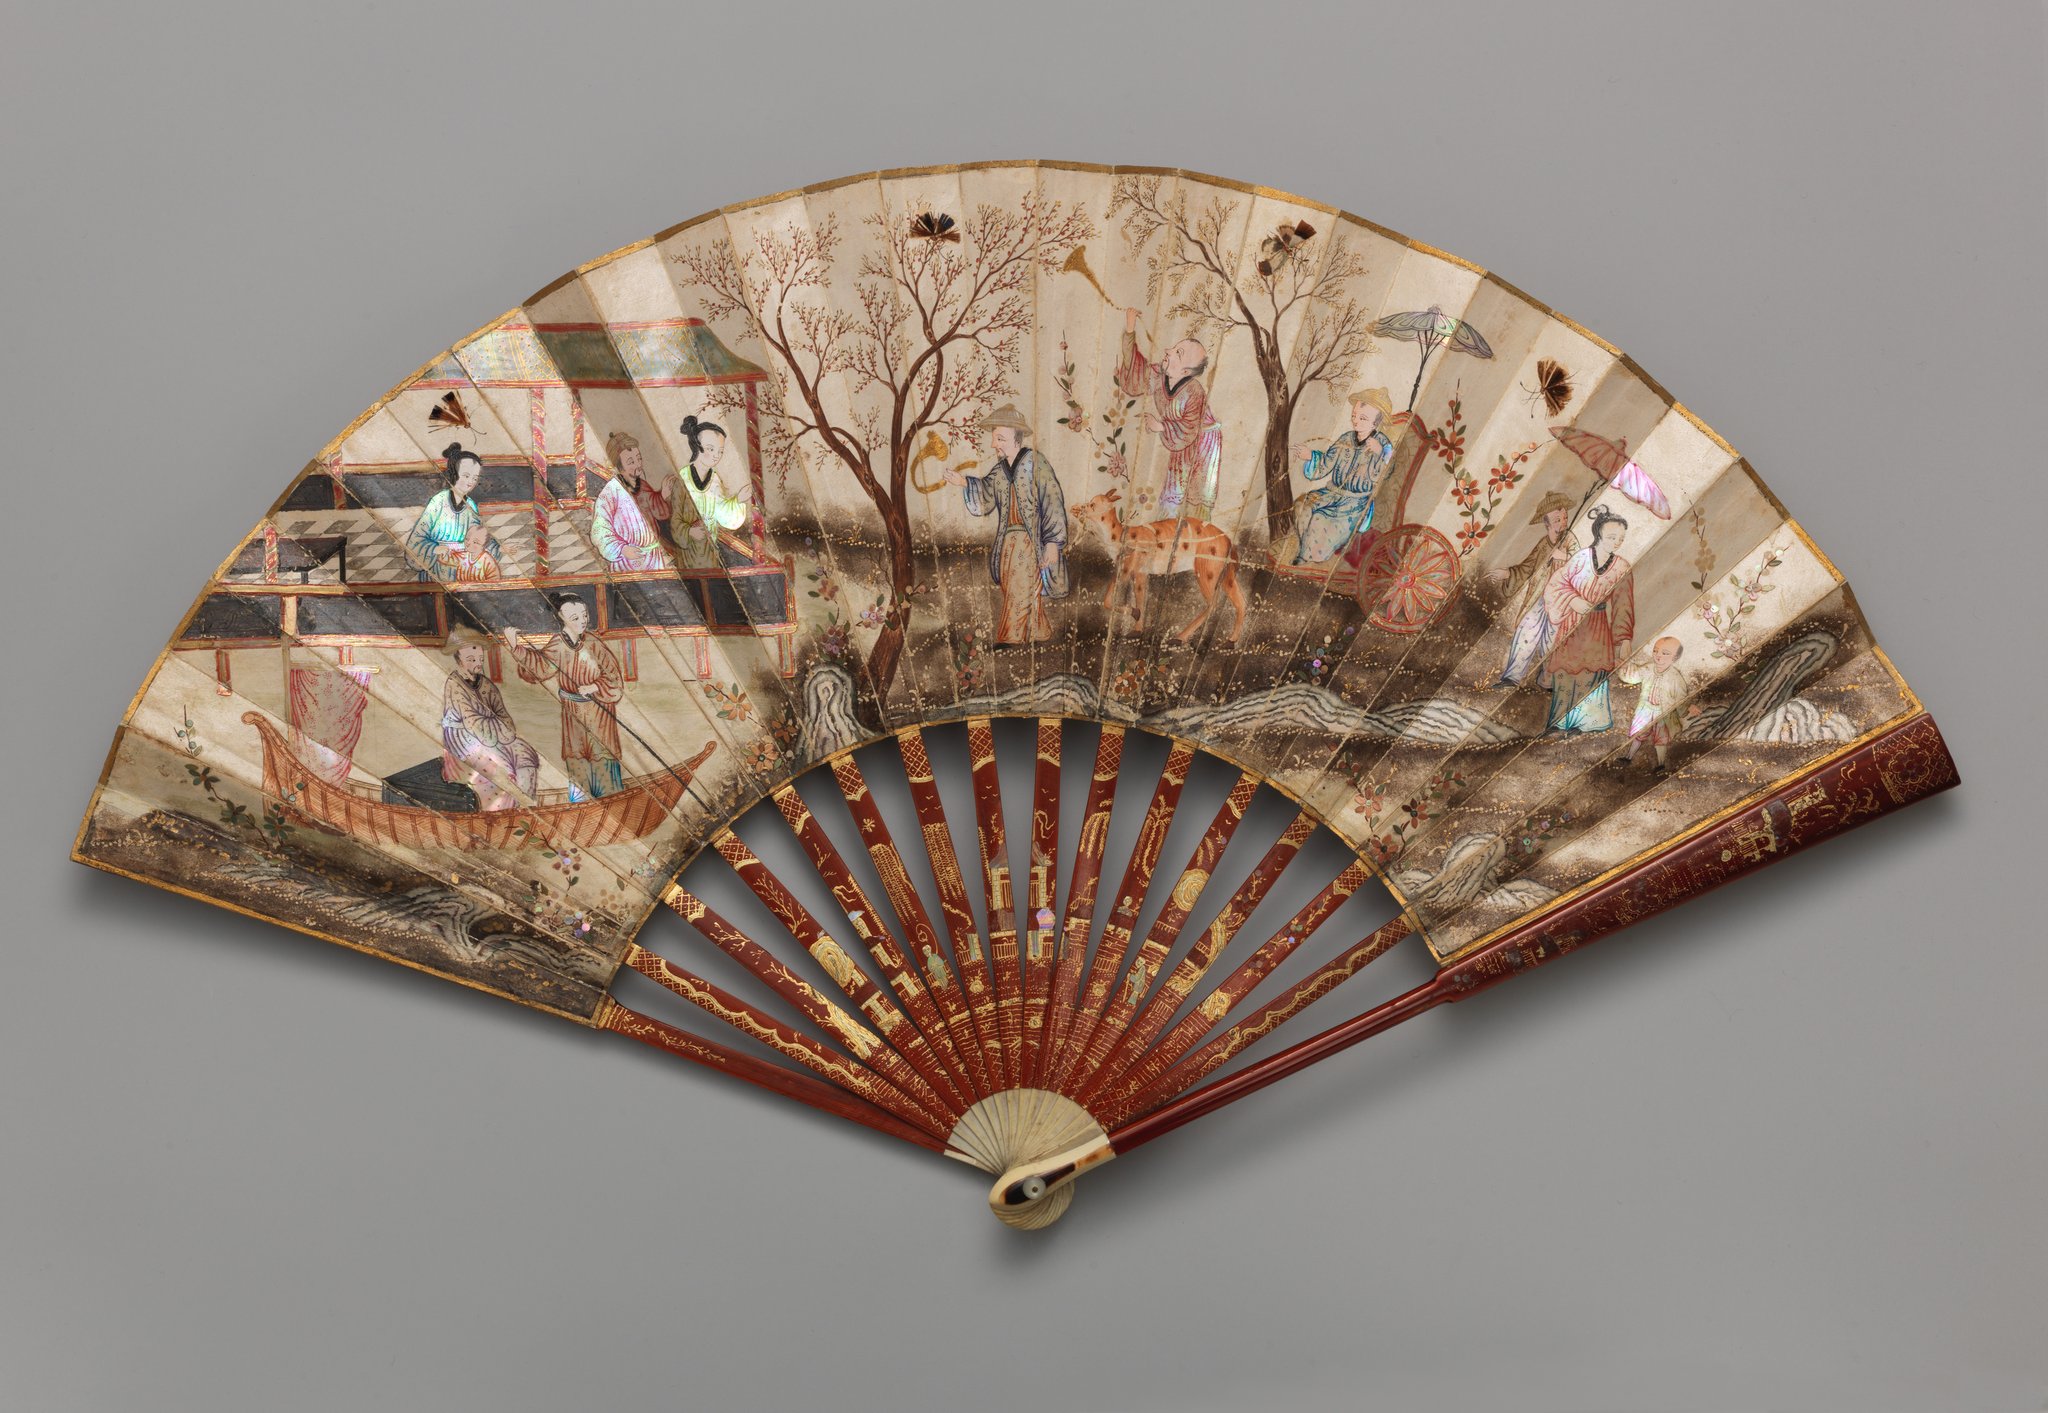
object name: fan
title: Folding Fan with Scene of Figures in a Landscape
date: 1734-1766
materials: ivory, mother of pearl, paper, shell, wood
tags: animals,men,women,boats,carts